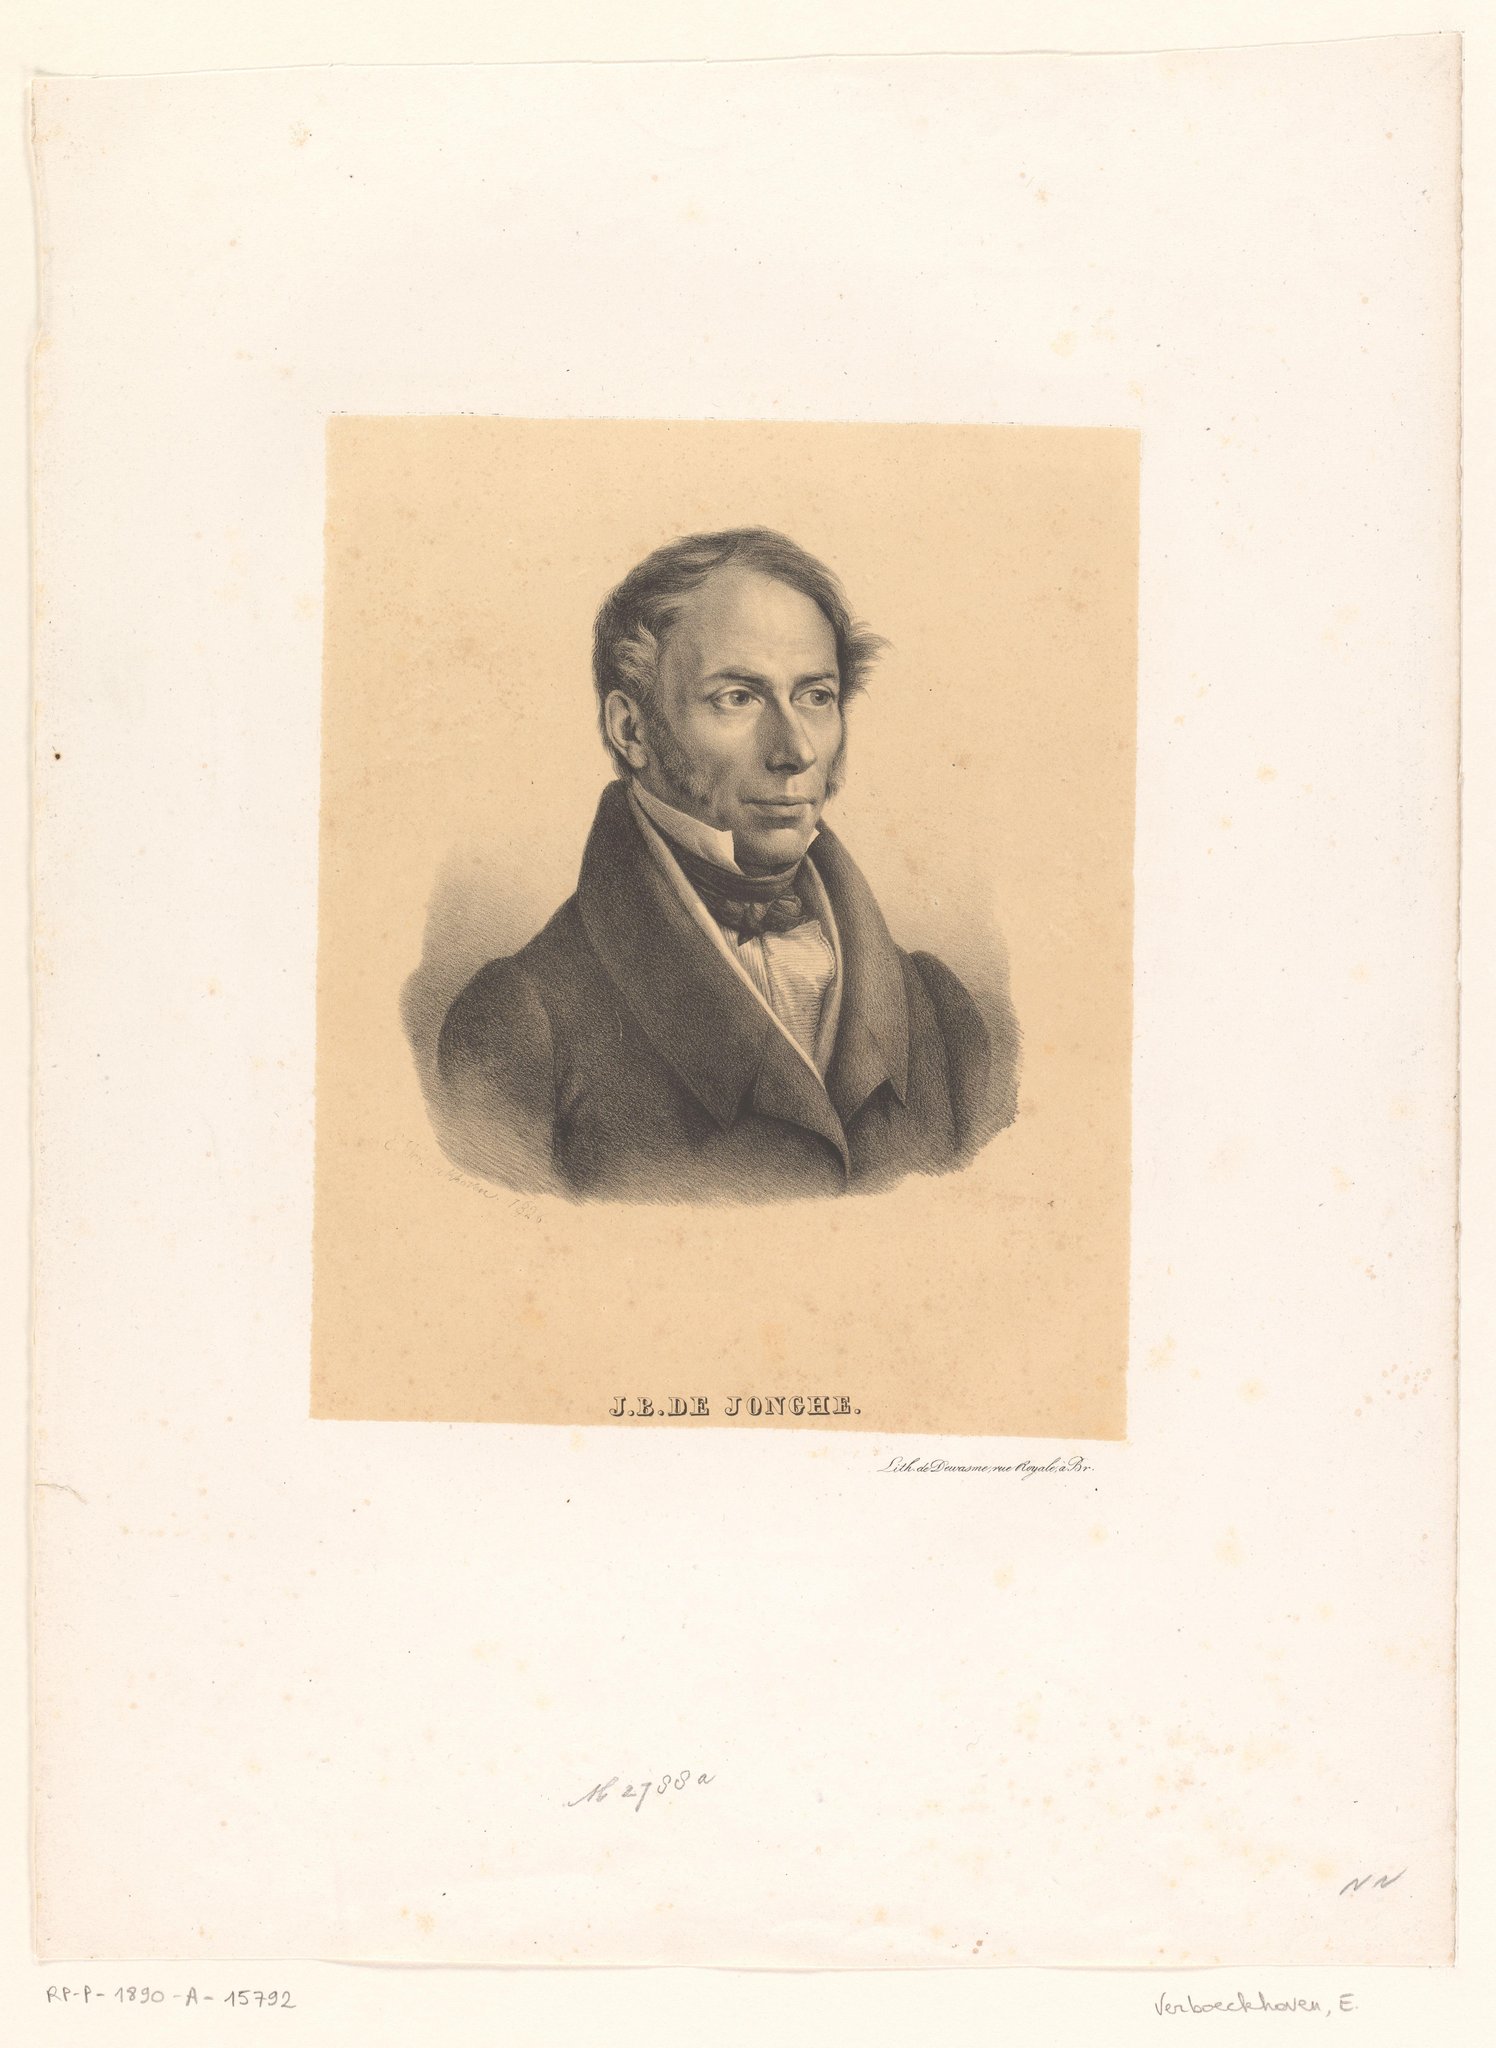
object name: print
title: Portret van Jan Baptiste De Jonghe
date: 1828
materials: paper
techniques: tone lithography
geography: brussels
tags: painter, jan baptiste de jonghe, historical persons, portrait, self-portrait of painter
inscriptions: collector's mark: Lugt 2228